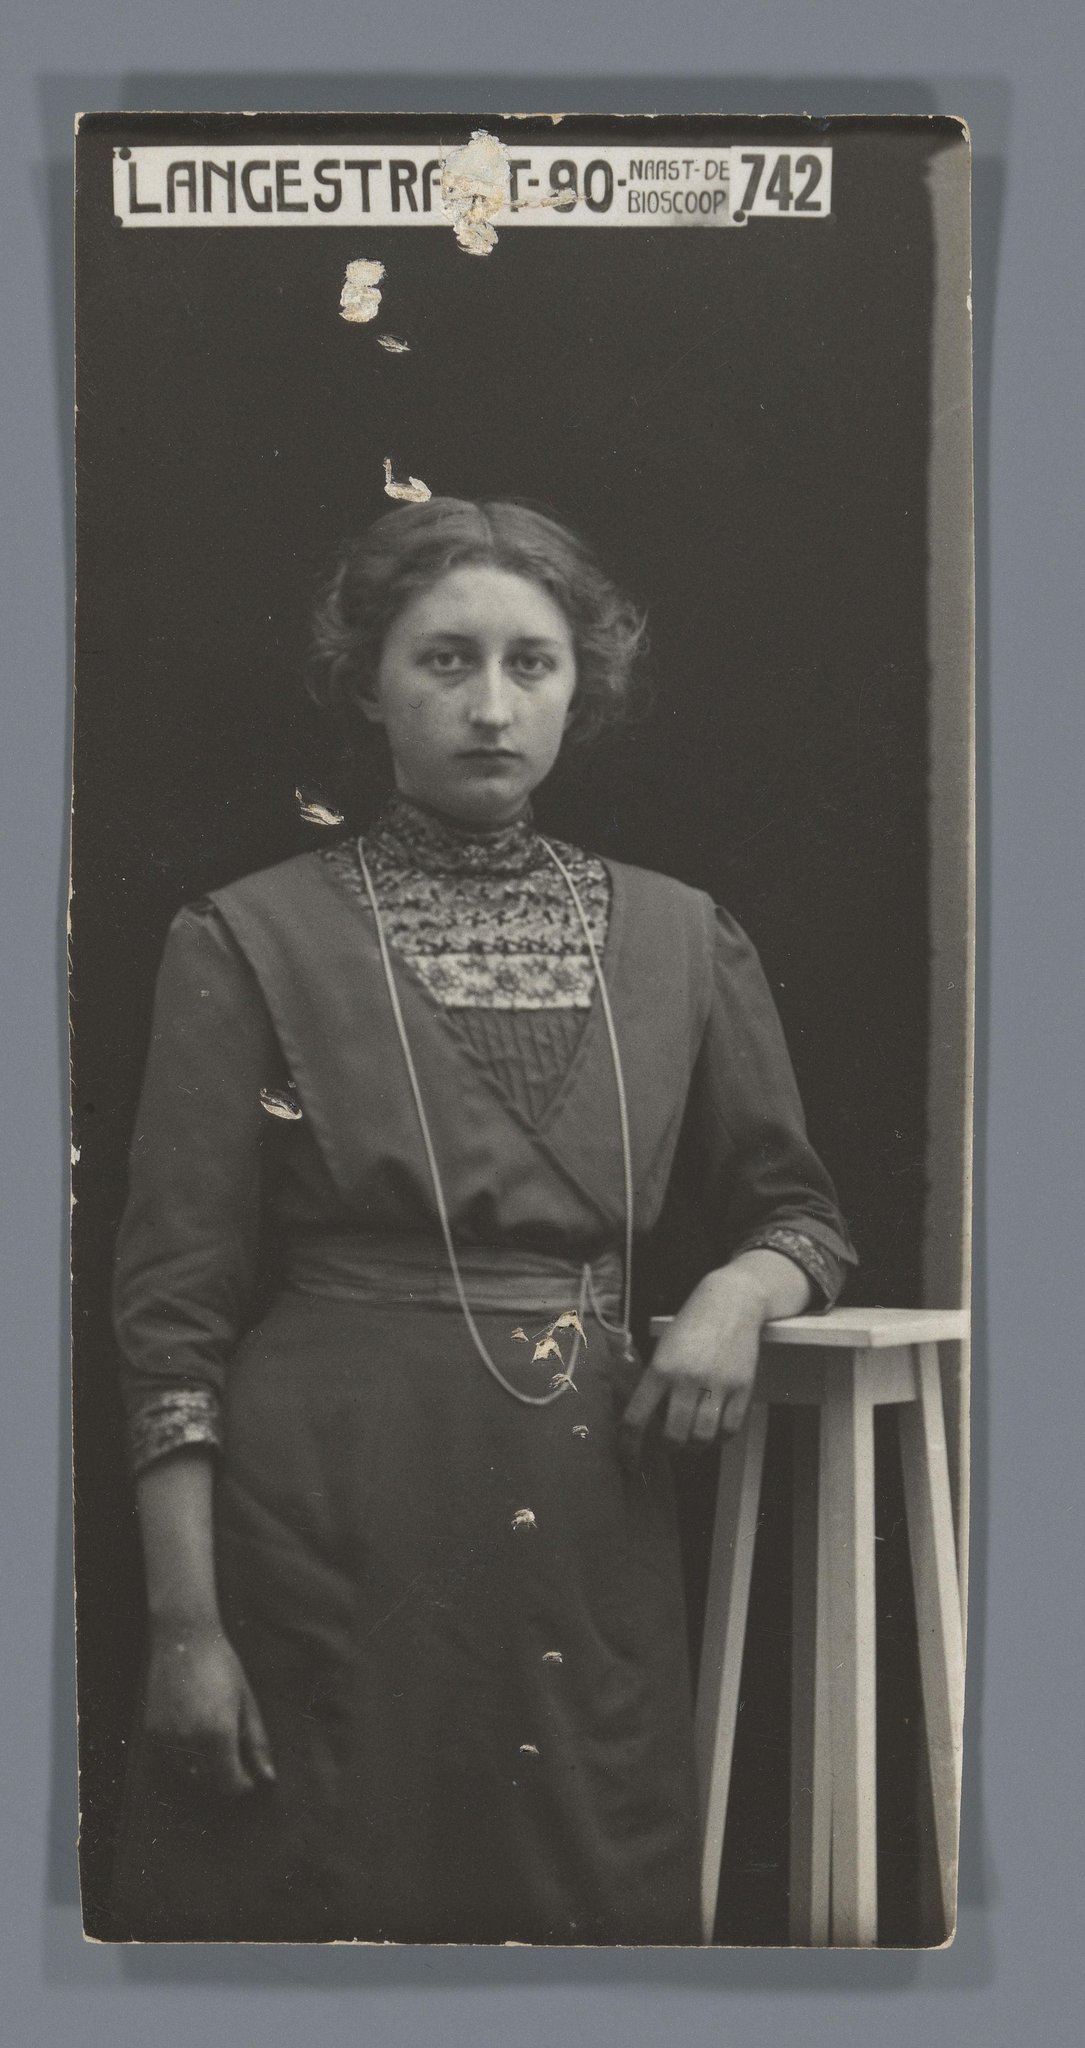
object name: snapshot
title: Rapid photographs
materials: photographic support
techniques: gelatin silver print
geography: alkmaar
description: Between 1912 and 1930, anyone could have their portrait taken at the many so-called rapid photography studios in the shopping streets of mainly (medium) large-size European cities. As if on an assembly line, the youngest clerk shot the photographs with a special camera and in artificial light and developed them. Later in the day, the customer collected a sheet with 12 portrait photos for 25 cents. This form of photographic mass production gave rise to a fascinating tableau of boys, girls, men and women not previously seen in photographs; candid and informal. There were at least 150 quick-photo studios, from Alkmaar to Zutphen. Many called themselves ‘American,’ mistakenly as it turns out because hardly any examples from that country have been found.